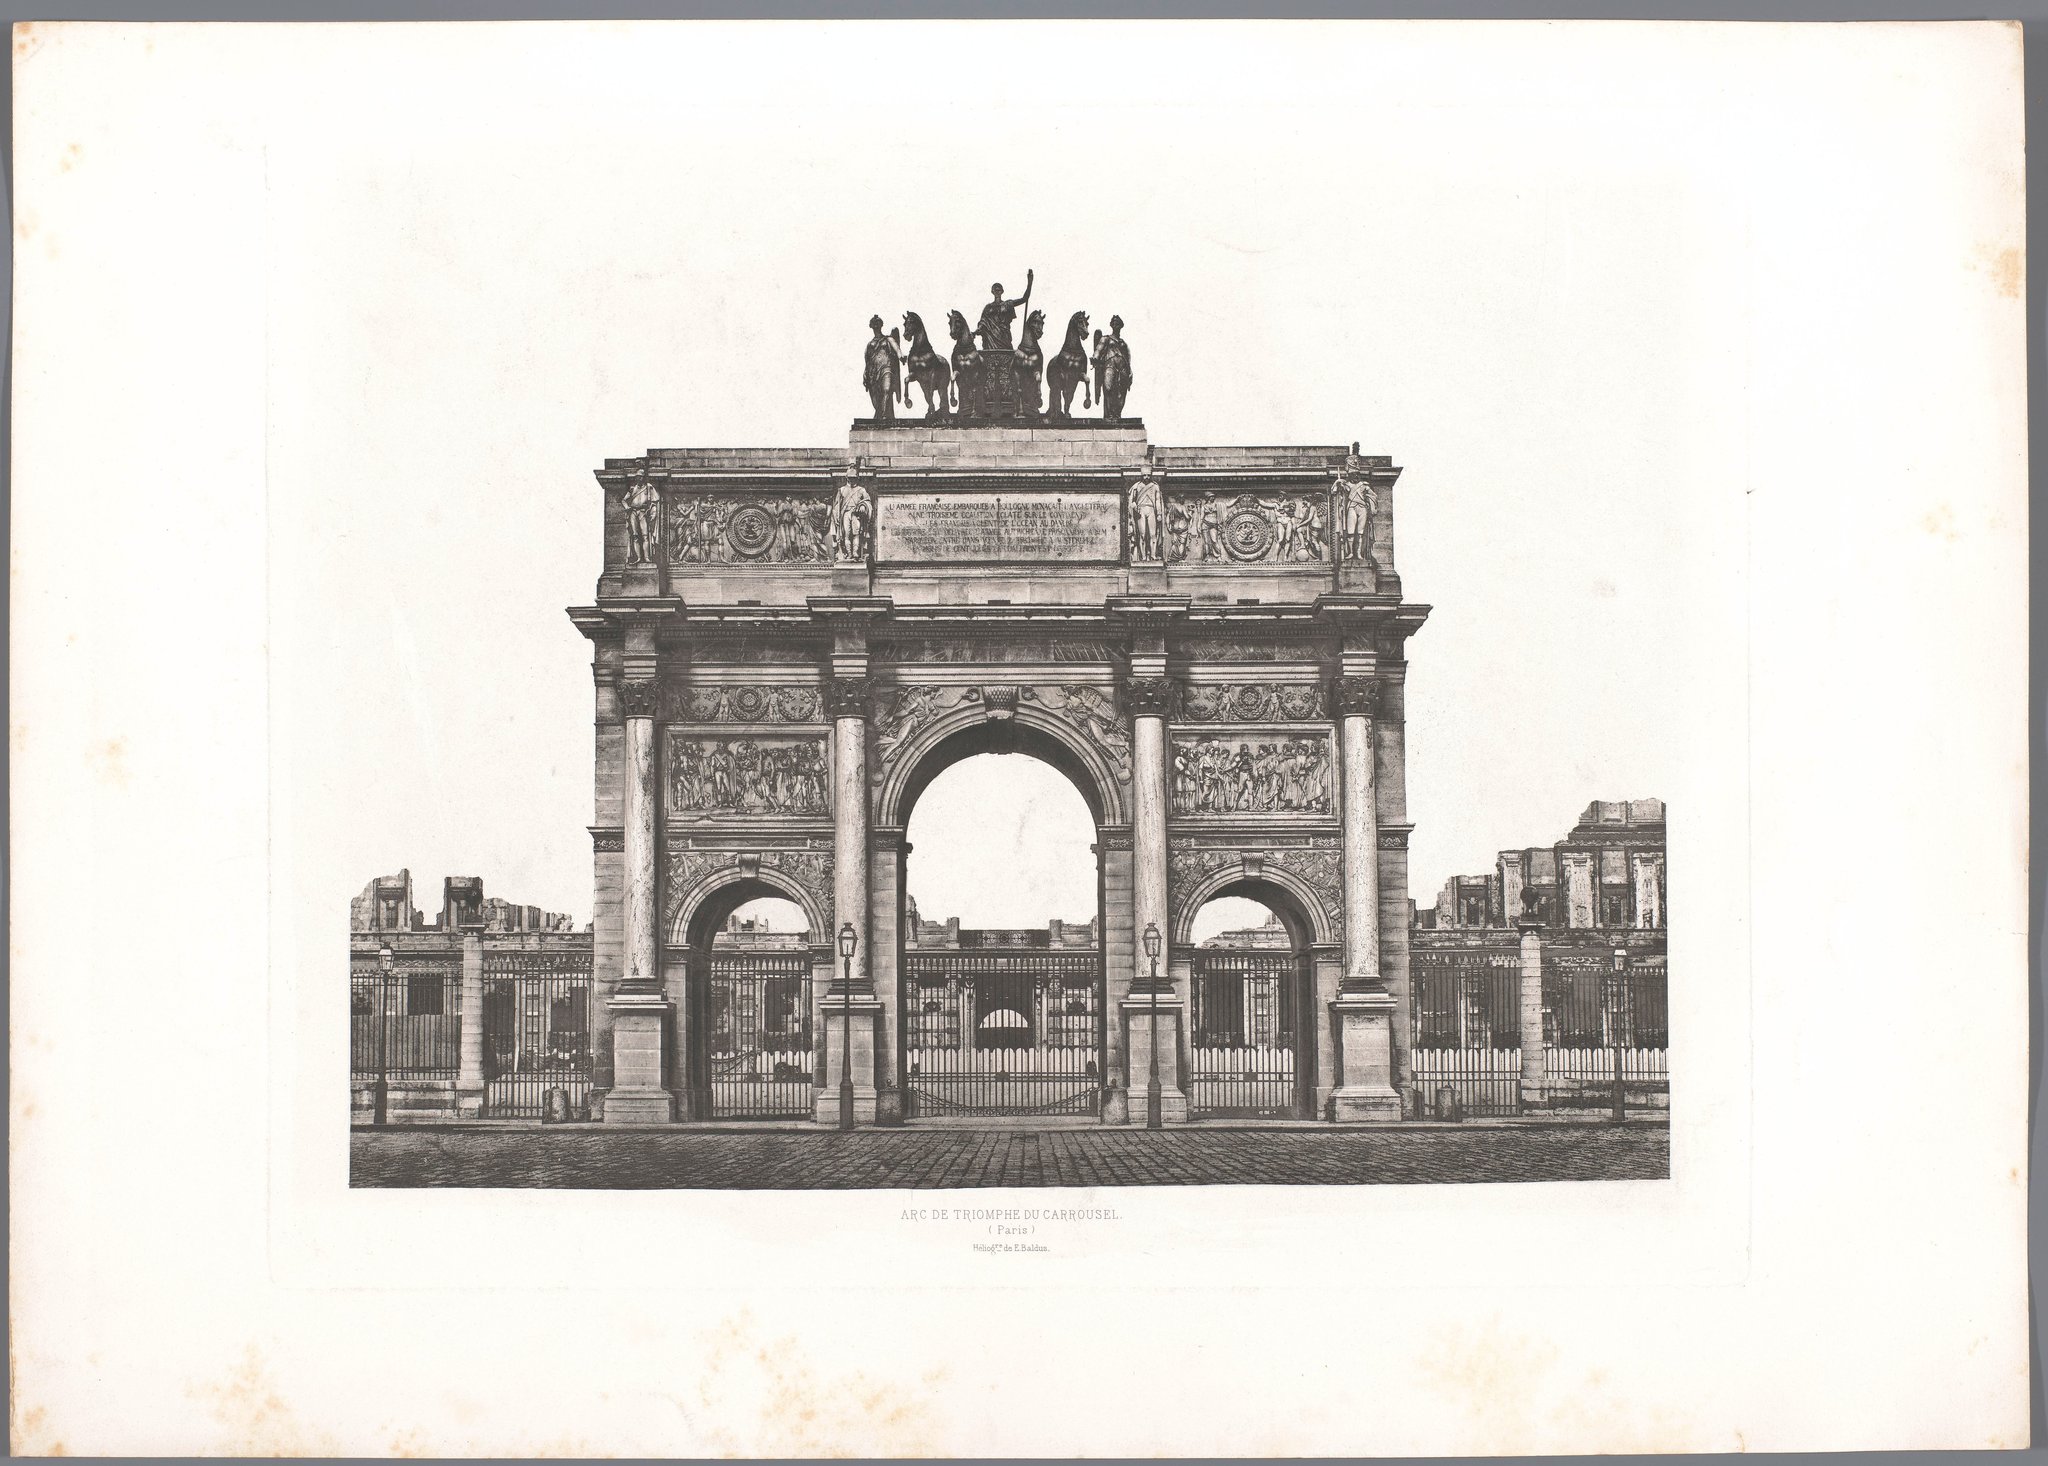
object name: photomechanical print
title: Arc de Triomphe du Carrousel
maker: édouard denis baldus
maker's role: fotograaf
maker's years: 1813-1889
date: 1865-1875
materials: paper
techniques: photoaquatint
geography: place du carrousel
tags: triumphal arch, quadriga